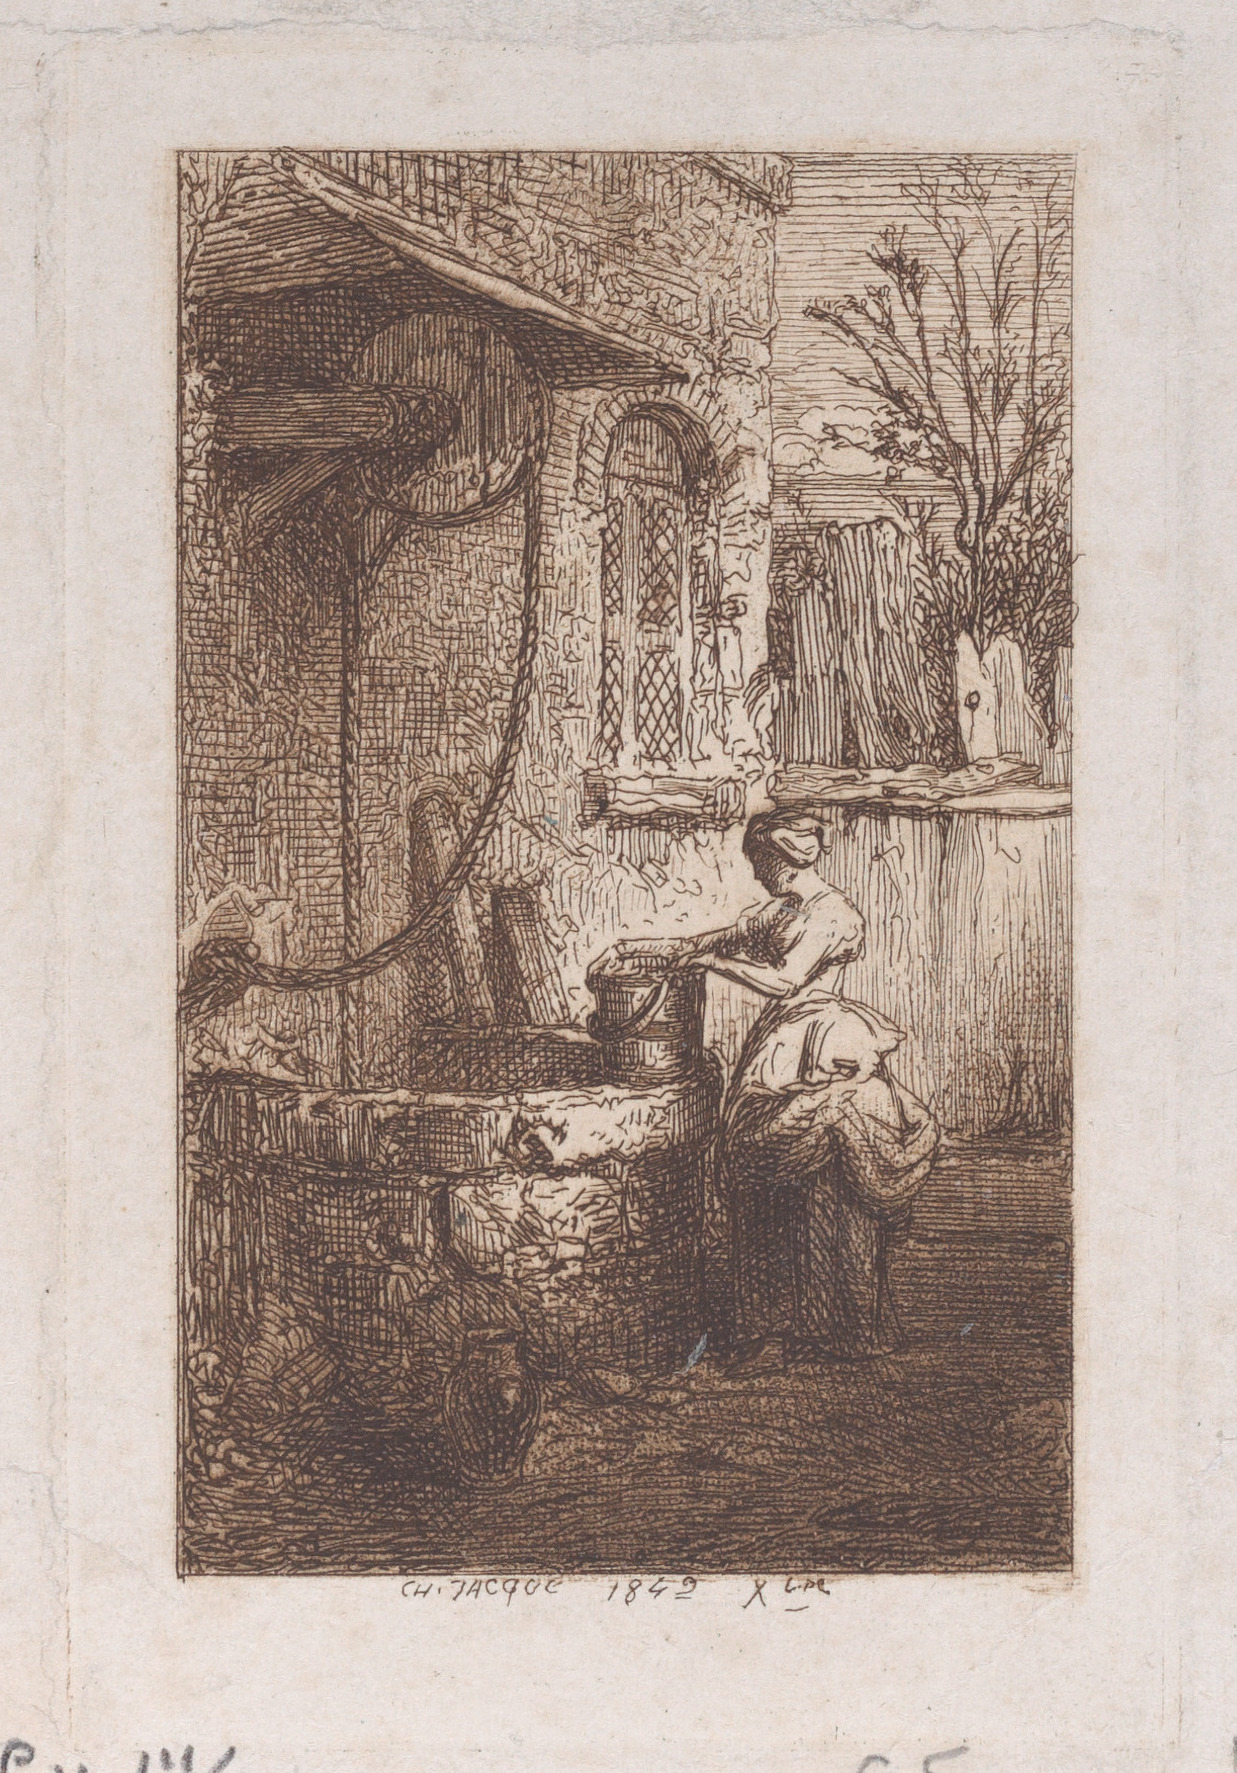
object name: print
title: Woman at a Well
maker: charles émile jacque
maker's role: artist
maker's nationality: french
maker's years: 1813-1894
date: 1842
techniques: etching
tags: wells,women